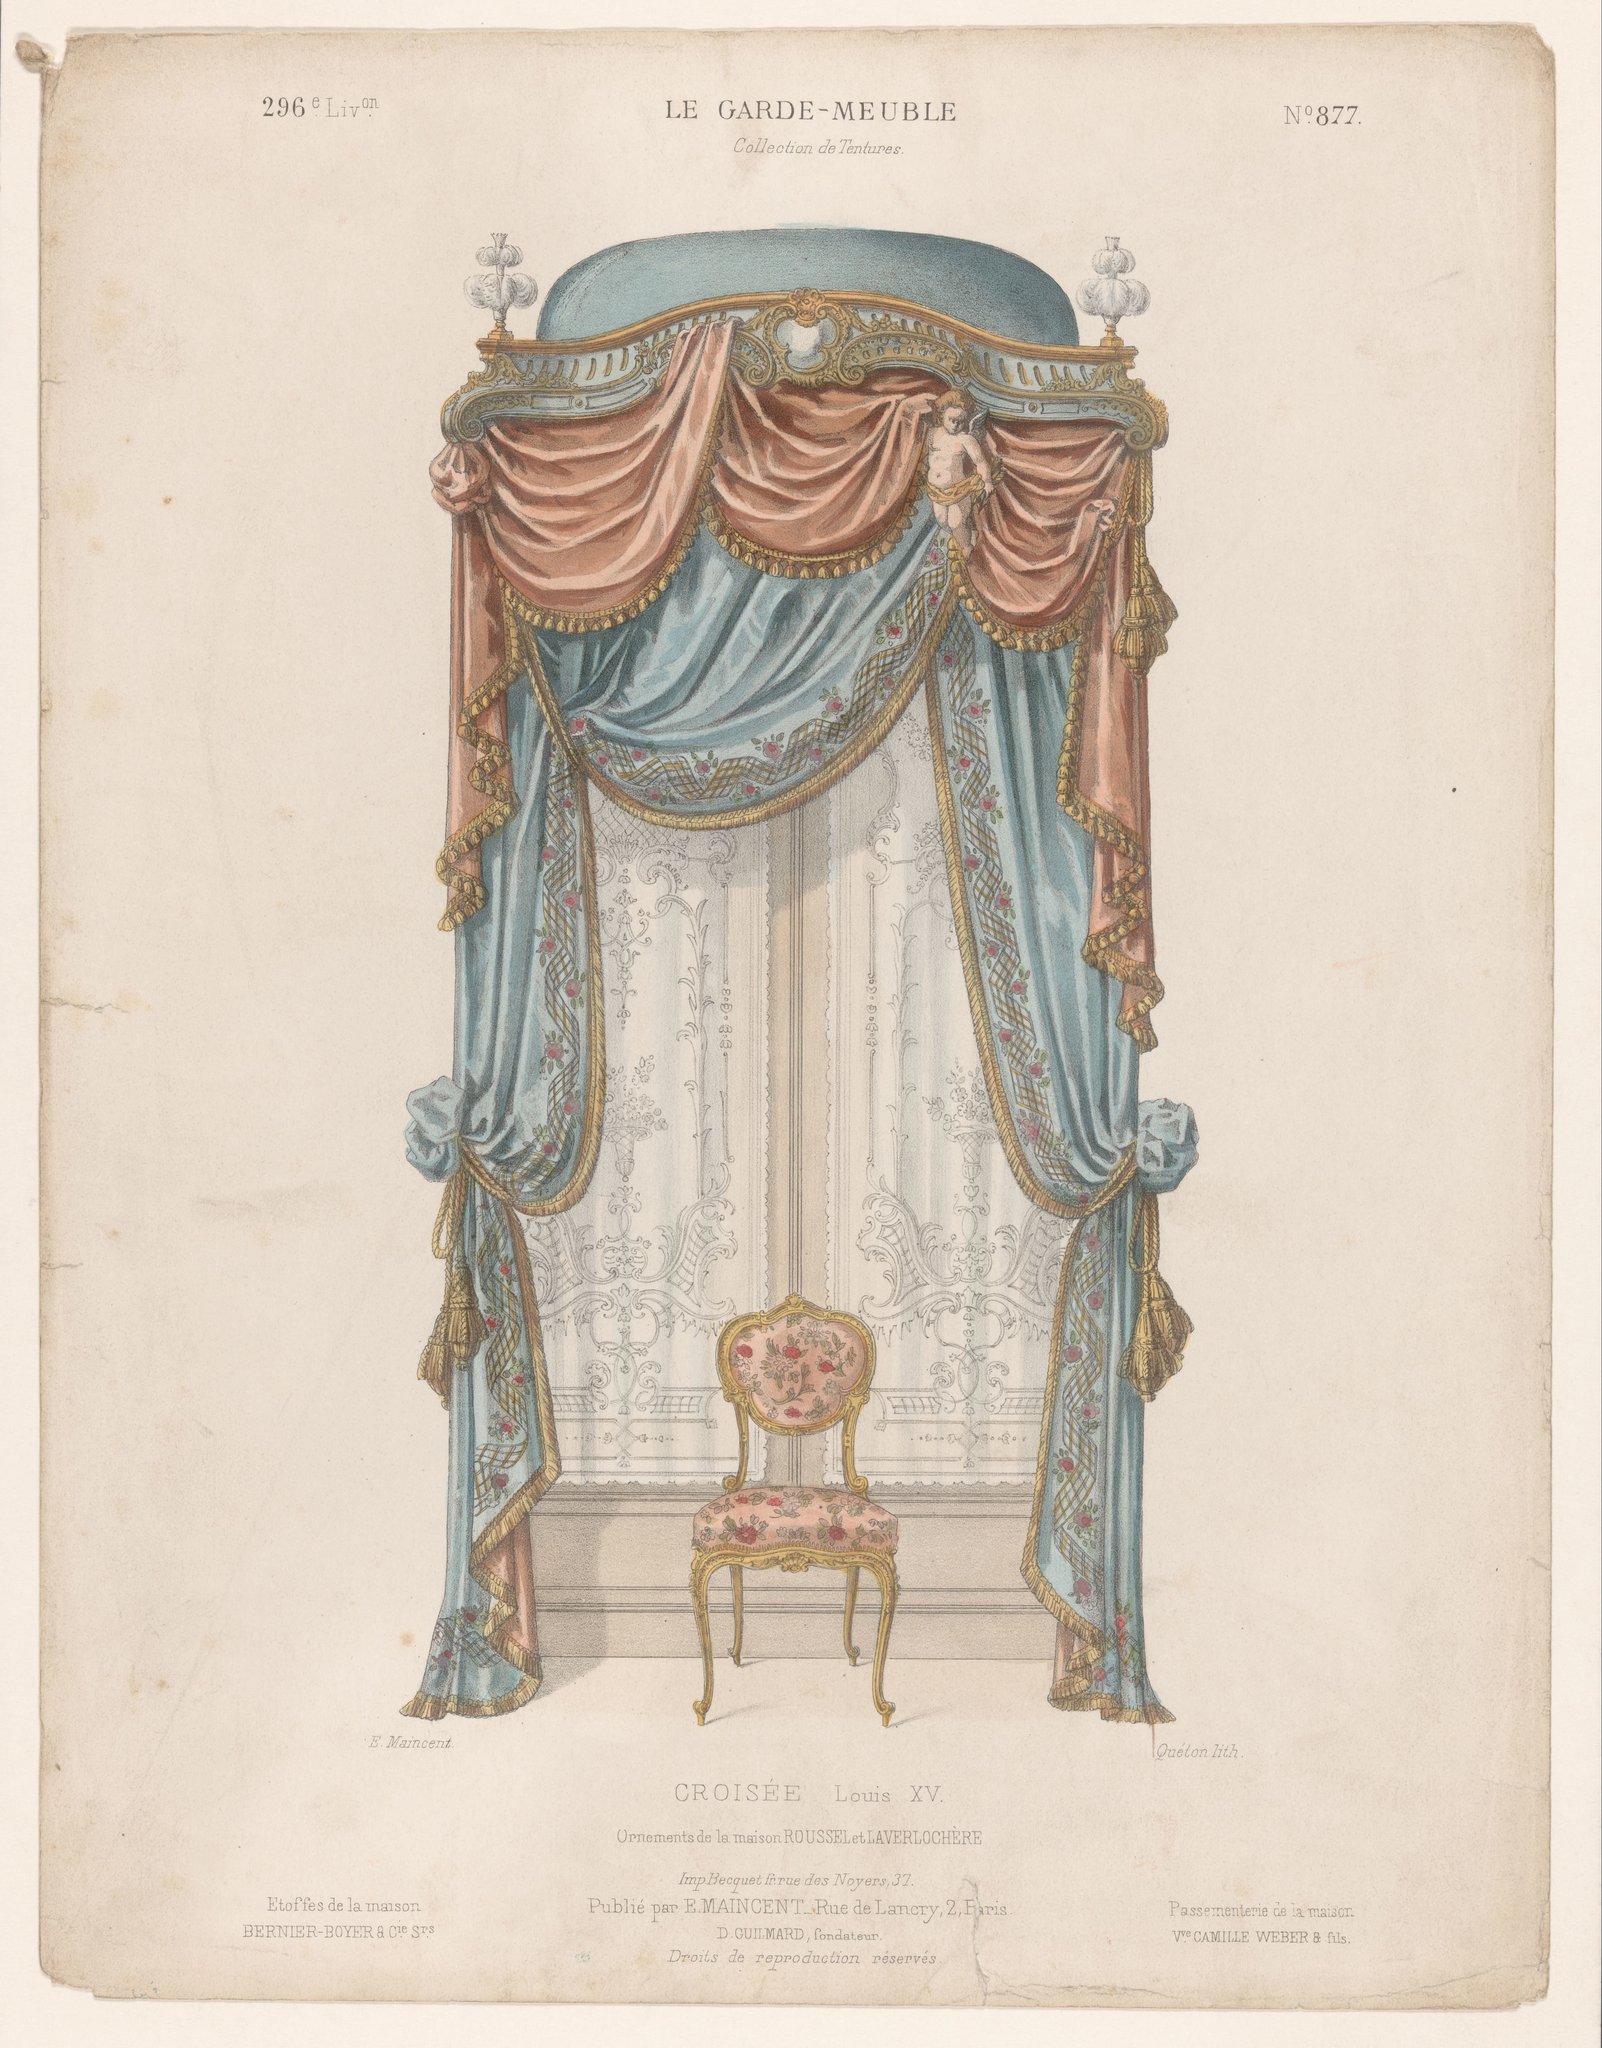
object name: print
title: Le Garde-Meuble / Collection de Tentures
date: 1885-1895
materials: paper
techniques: hand coloring, lithograph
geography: paris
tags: window, hangings and drapery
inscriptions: : ‘Droits de reproduction réservés.’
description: Kruisvenster met gedrapeerde gordijnen in Lodewijk XV-stijl. Prent uit 296e Livraison.